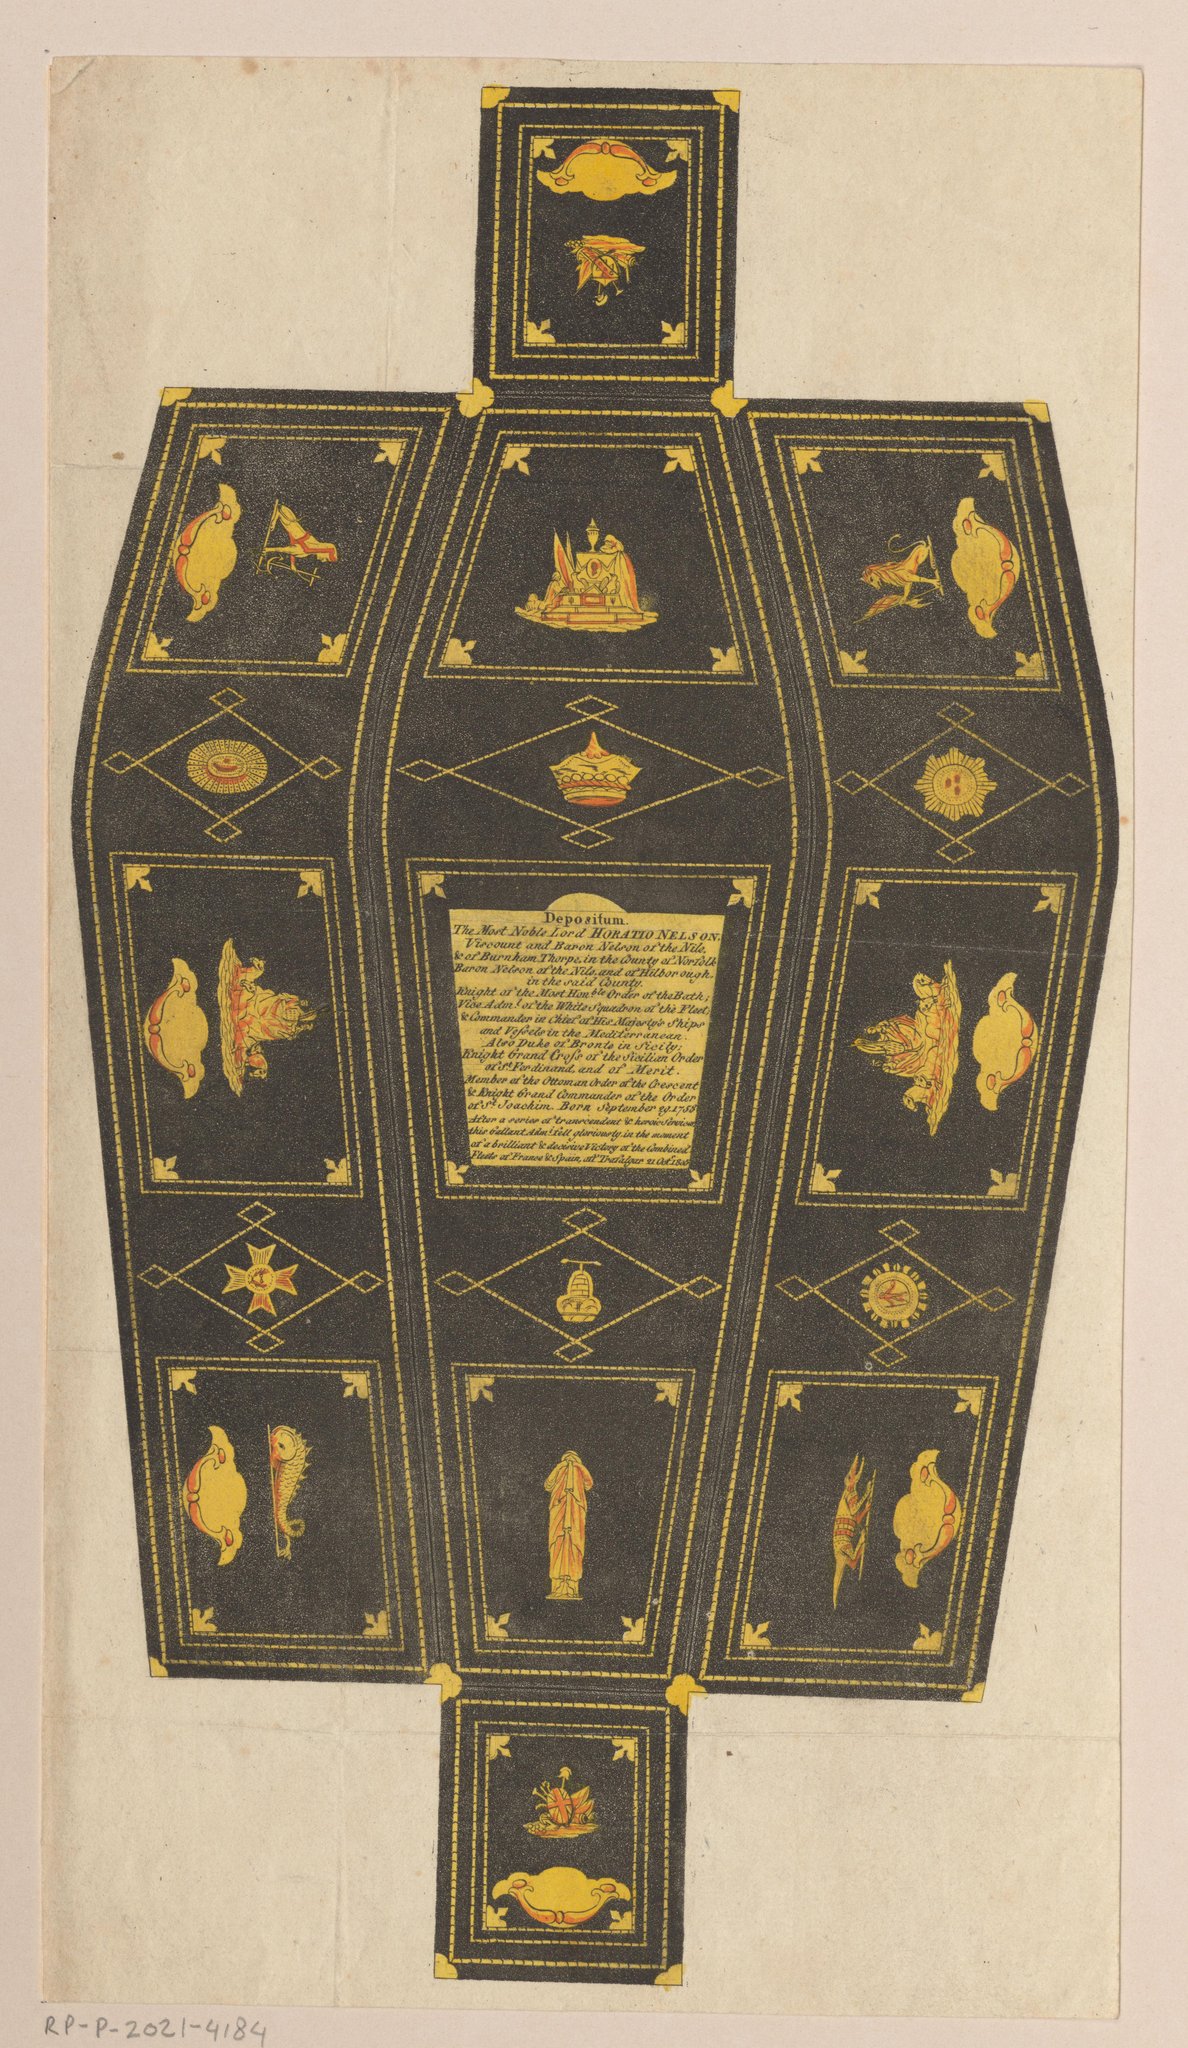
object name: print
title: Doodskist van Horatio Nelson, hertog van Bronte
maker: Anonymous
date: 1806-1810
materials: paper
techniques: aquatint, etching, hand coloring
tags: horatio nelson (hertog van bronte), historical persons, coffin